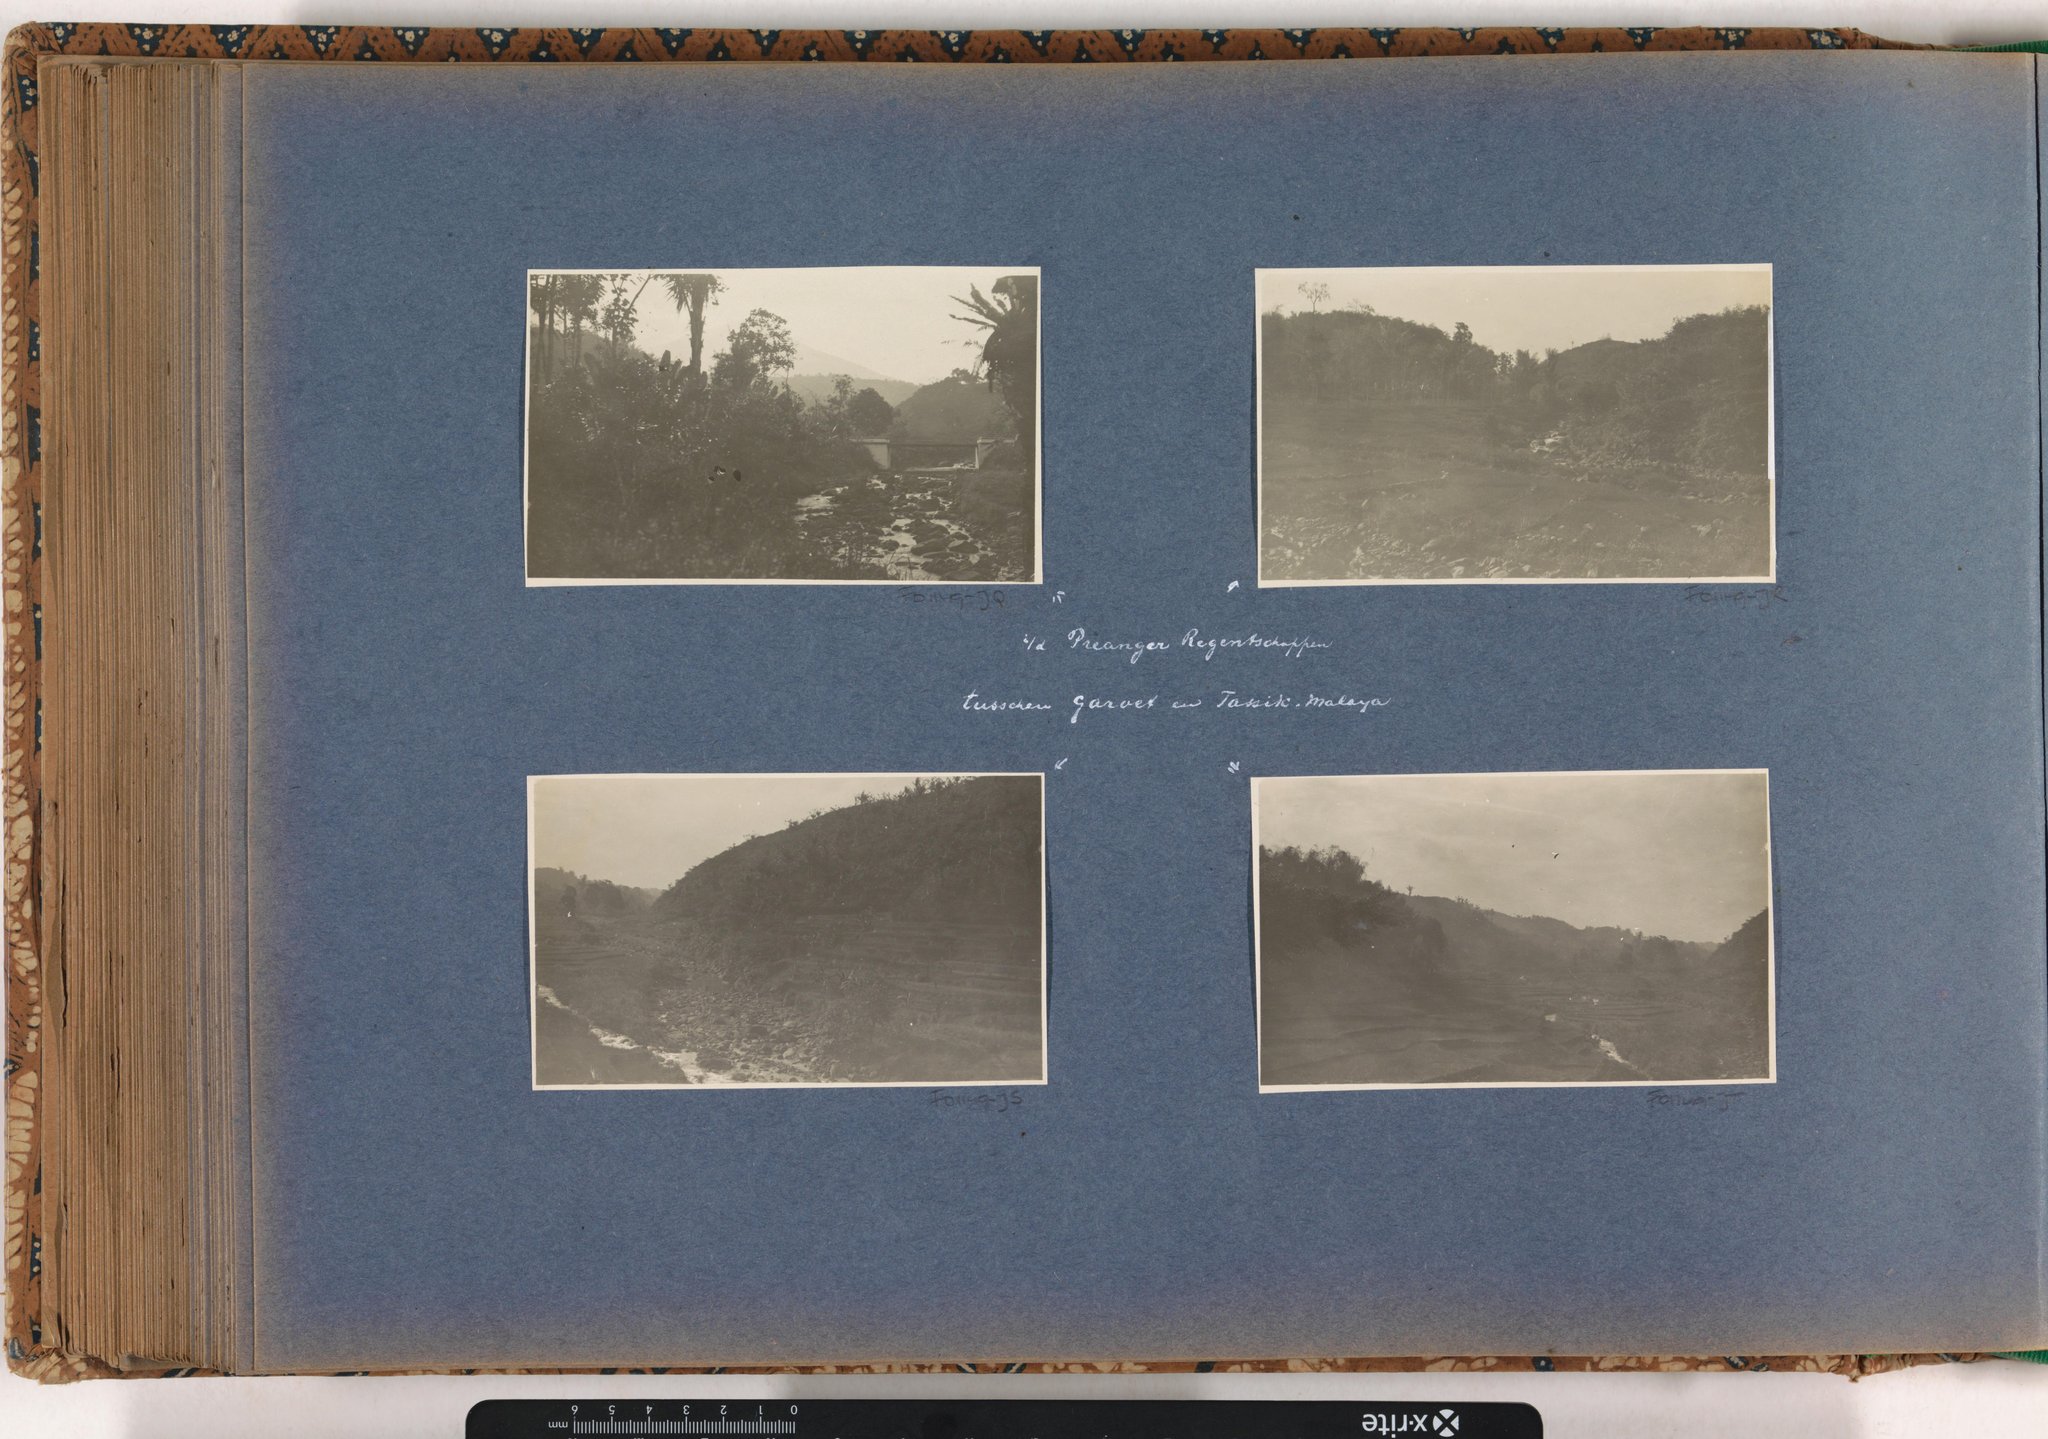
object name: photograph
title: Landschap met terrassen tussen Garut en Tasikmalaya op Java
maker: Anonymous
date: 1900-1920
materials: paper, photographic support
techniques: gelatin silver print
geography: java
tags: cultivated land (in tropical and sub-tropical regions), java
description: Onderdeel van reisalbum met foto's van bedrijvigheid en bezienswaardigheden op Sumatra en Java en van de reis naar en van Nederlands-Indië.